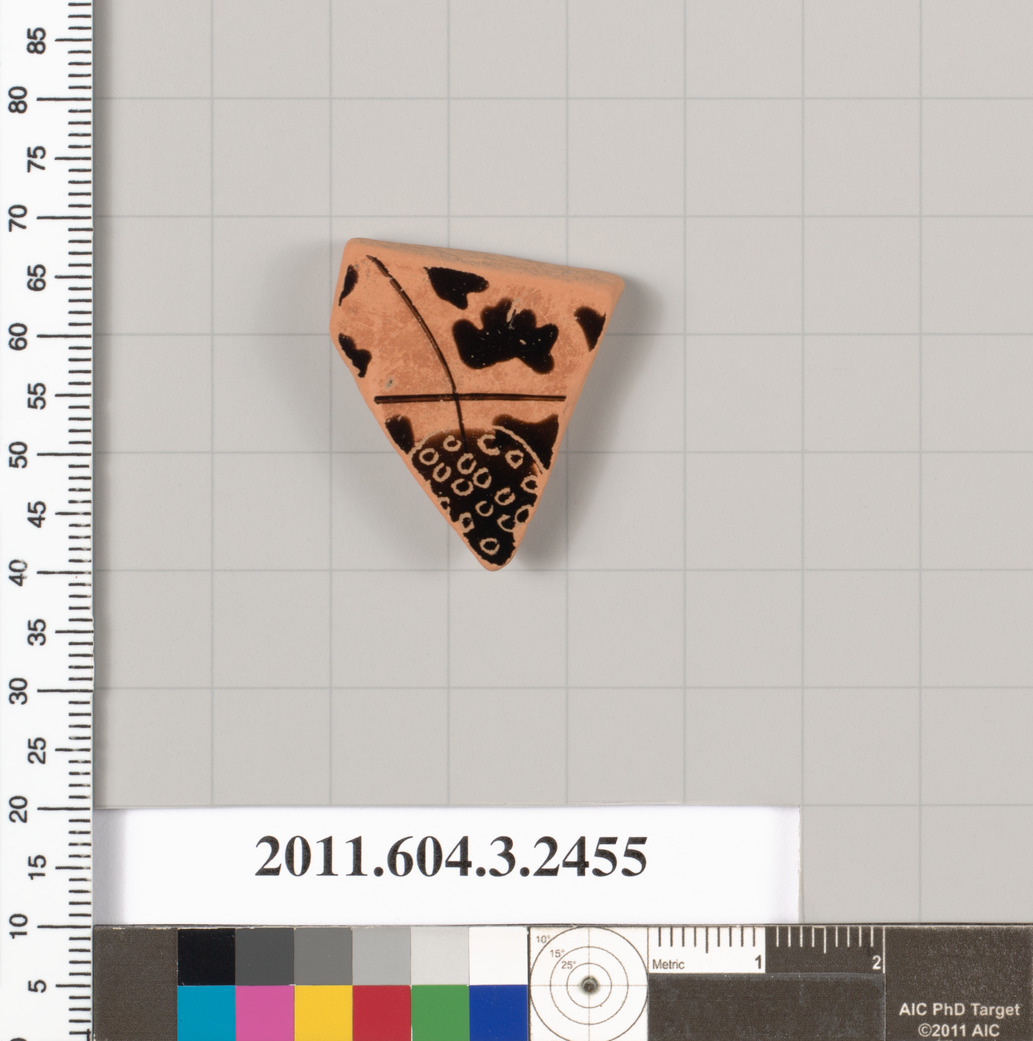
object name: kylix fragment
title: Terracotta fragment of a kylix: eye-cup (drinking cup)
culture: greek, attic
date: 530-510 BCE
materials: terracotta